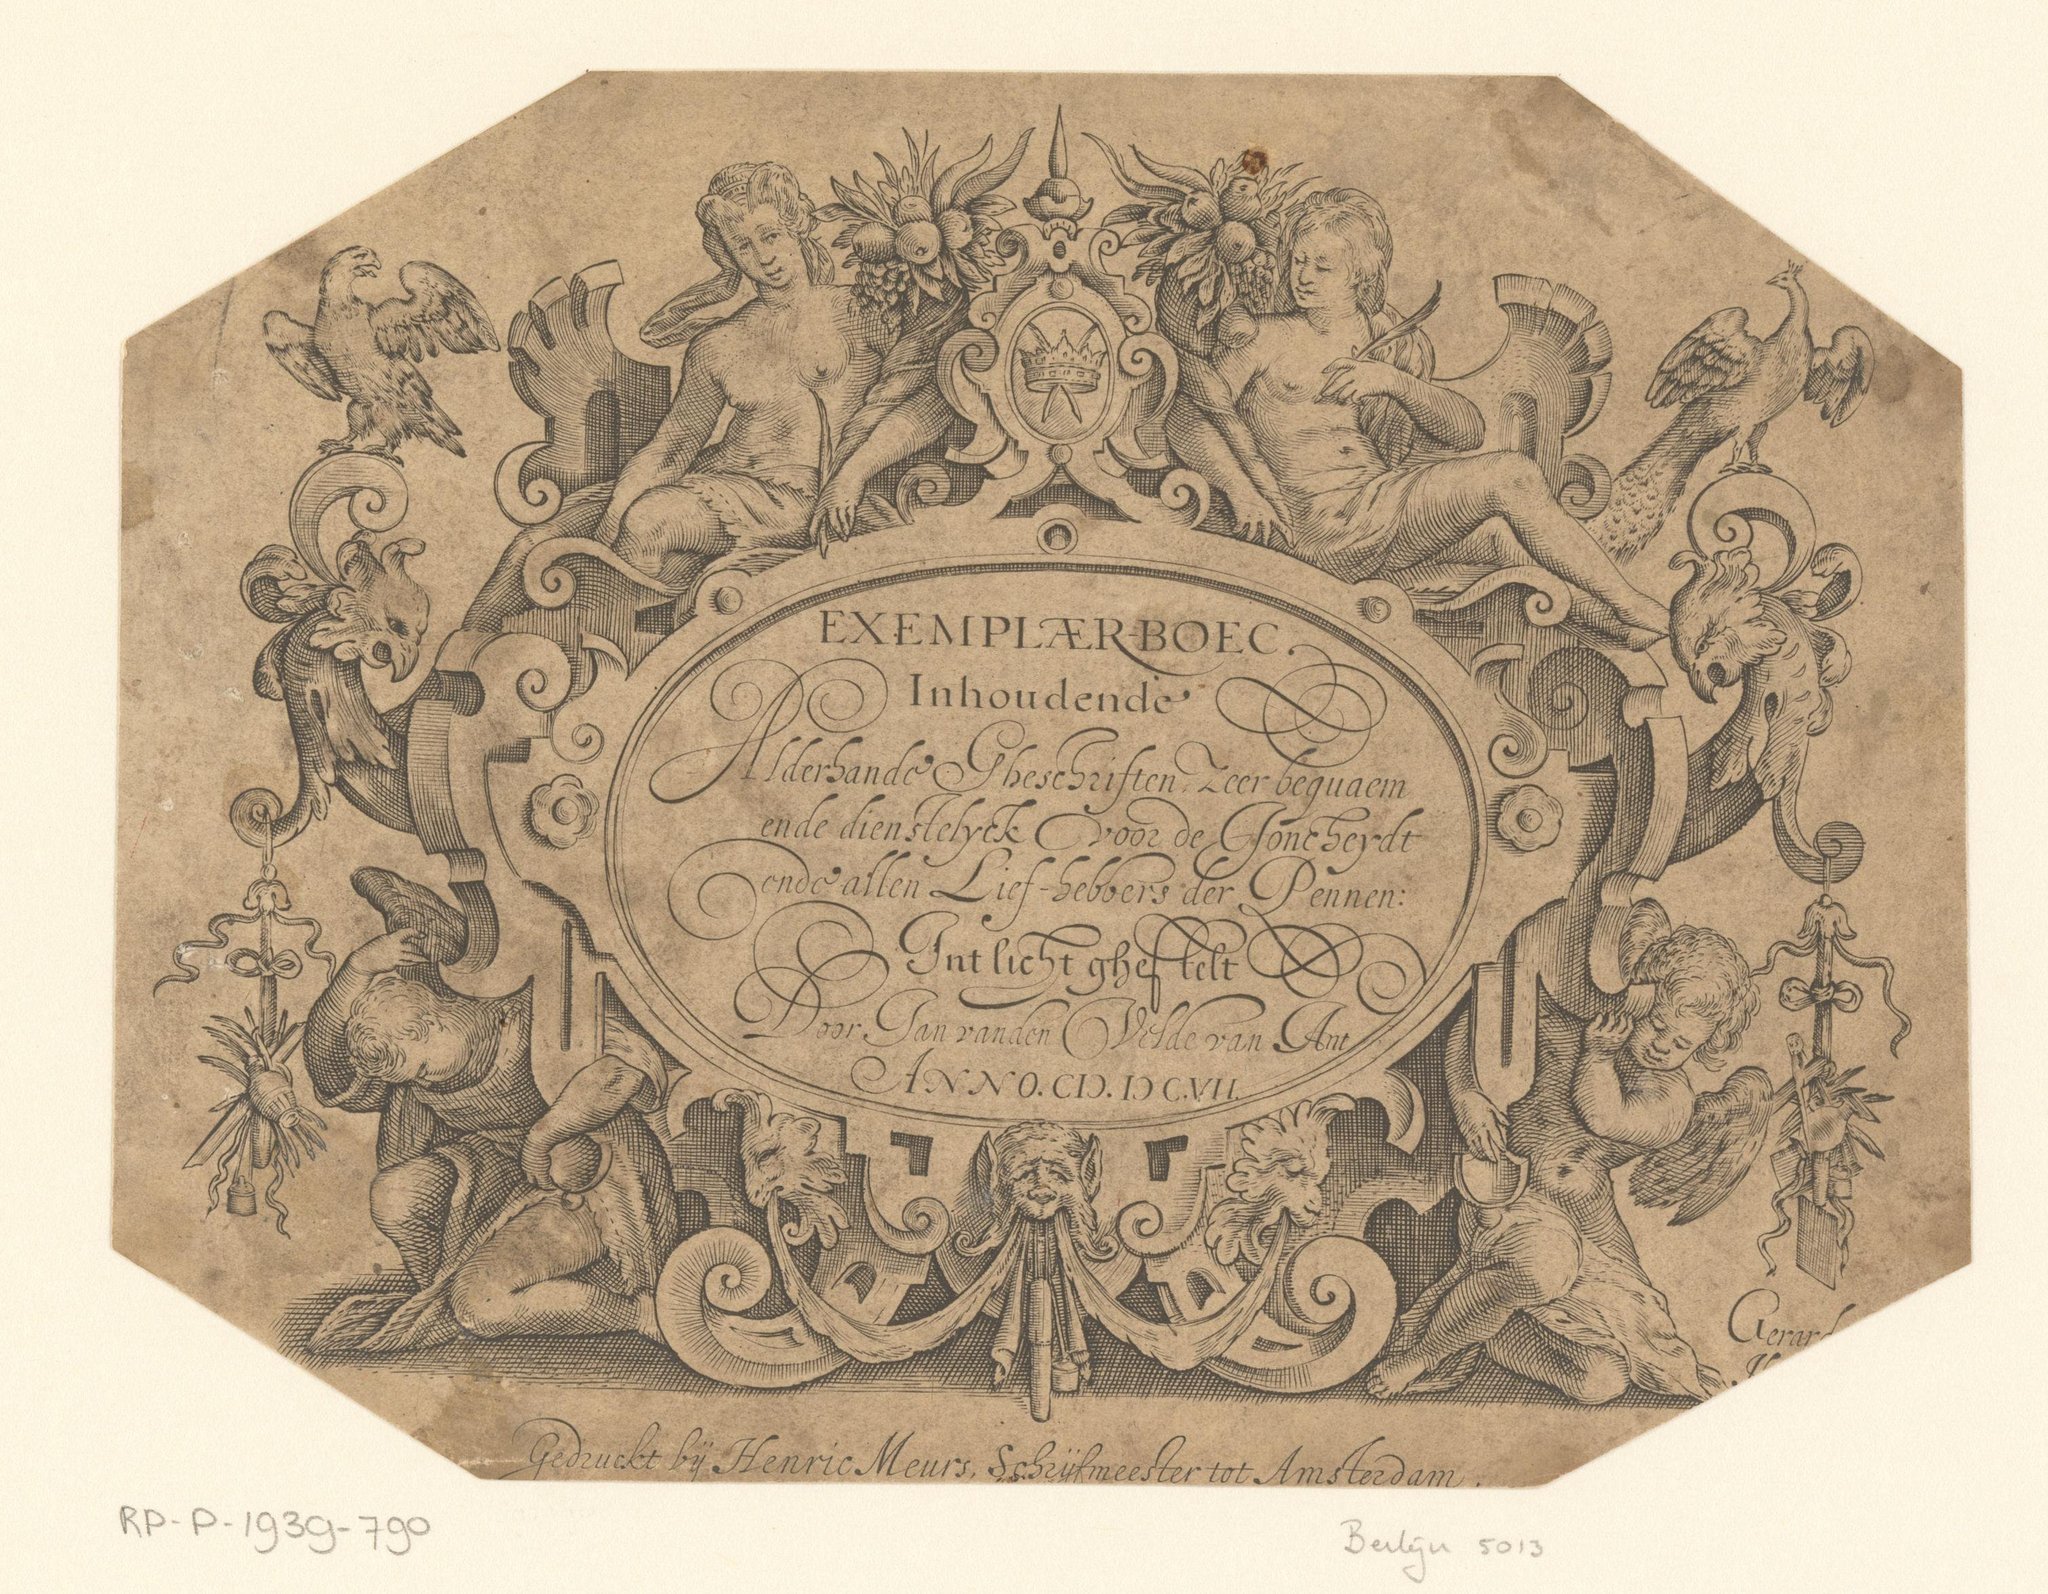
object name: ornament print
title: Exemplaer-boec Inhoudende Alderhande Gheschriften zeer bequaem ende dienstelyck voor de Joncheydt ende allen Lief-hebbers der Pennen:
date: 1607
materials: paper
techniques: engraving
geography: haarlem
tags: calligraphy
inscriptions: collector's mark: Lugt 2166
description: Een ornamentele ovale omlijsting met gekalligrafeerde serietitel. In de onderste hoeken zitten twee engelen, boven de omlijsting zitten twee vrouwen met schrijfveren en hoornen des overvloeds. Links en rechts van hen een adelaar en een pauw.